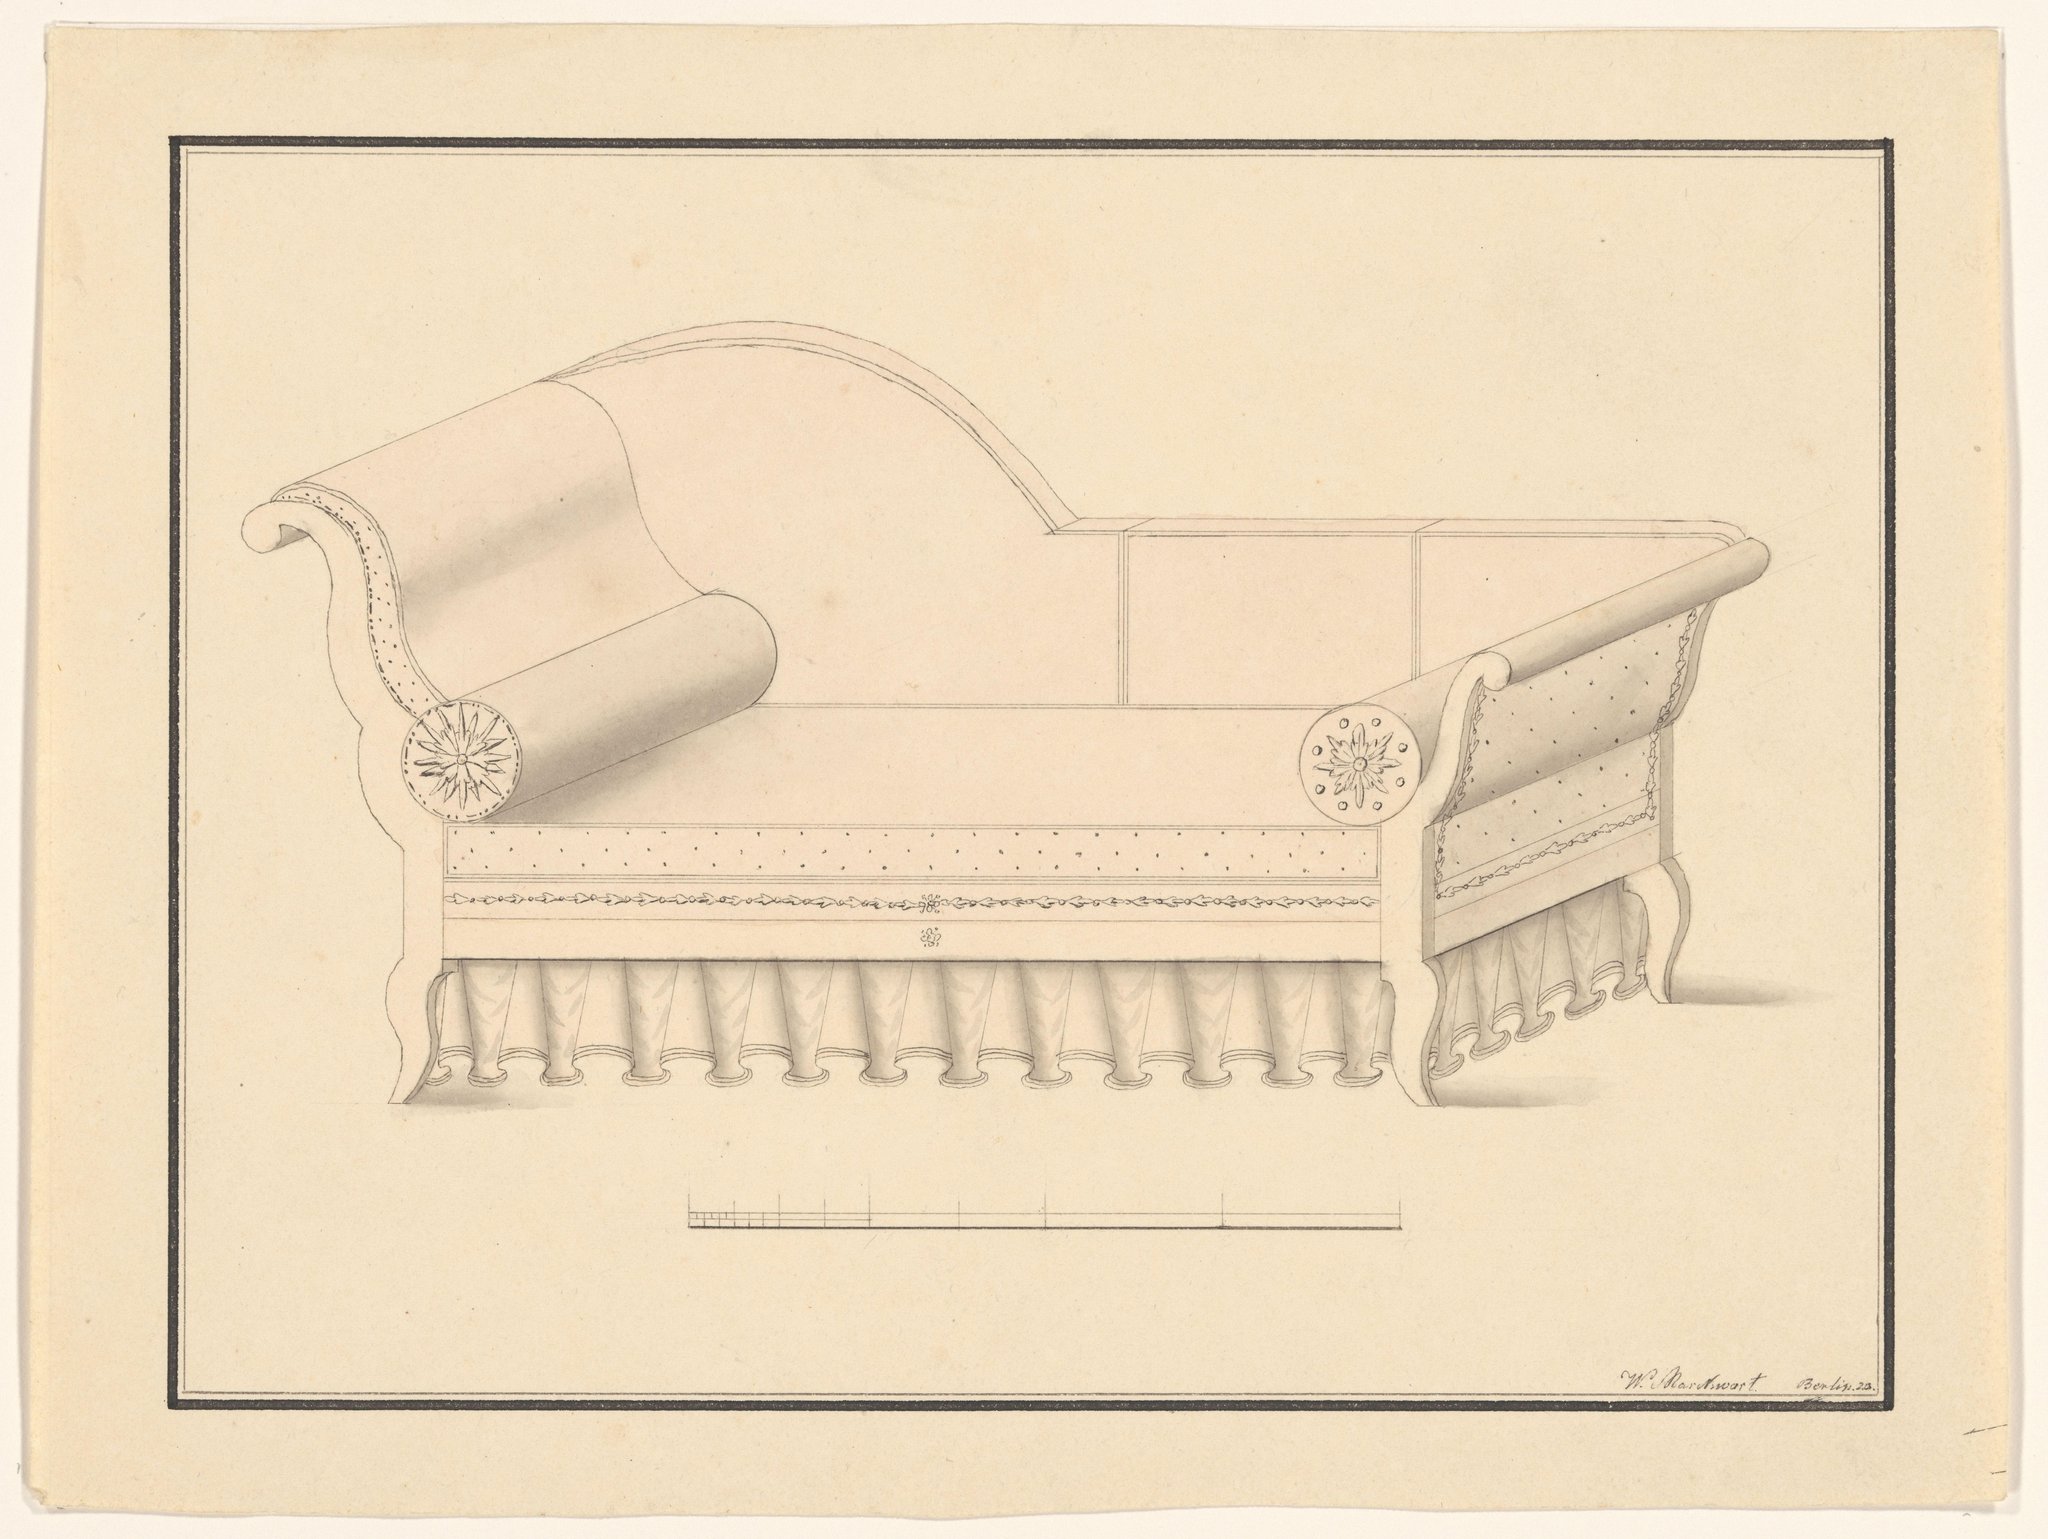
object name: design drawing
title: Ontwerp voor een beklede canapé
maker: carl wilhelm marckwort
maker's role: draughtsman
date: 1823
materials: ink, paper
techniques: brush, pen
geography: berlin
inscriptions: signature and date: ‘W.Marckwort. Berlin. 23’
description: Beklede canapé met een hoge en een lage zijleuning.